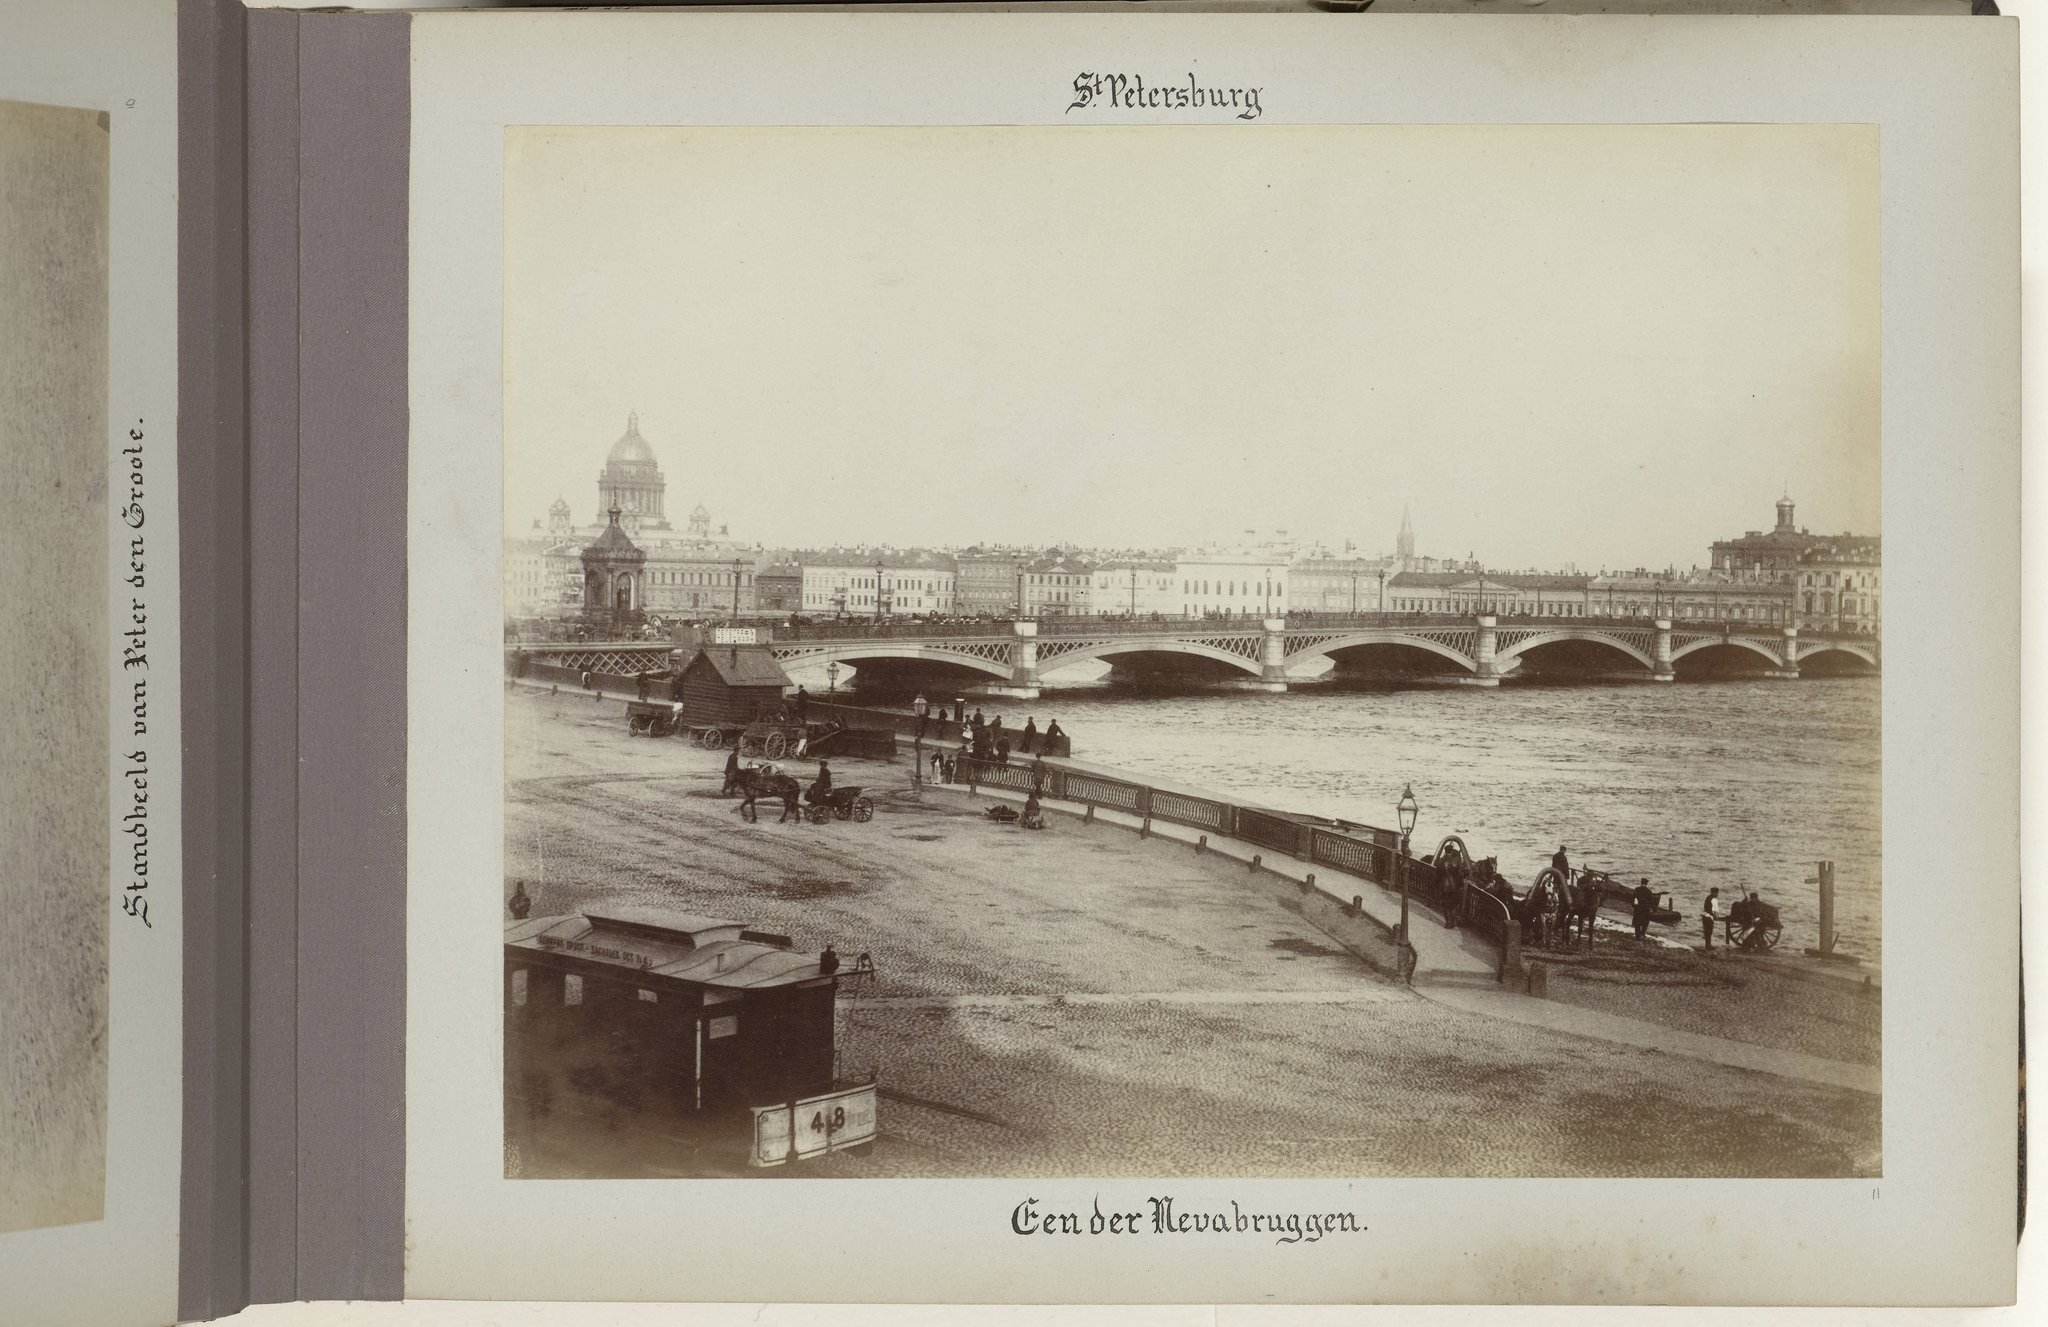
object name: photograph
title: Brug over de Neva in Sint-Petersburg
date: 1898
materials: paper, photographic support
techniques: albumen print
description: Een van de bruggen over de Neva in Sint Petersburg. Op de achtergrond is de stad Sint Petersburg zichtbaar.